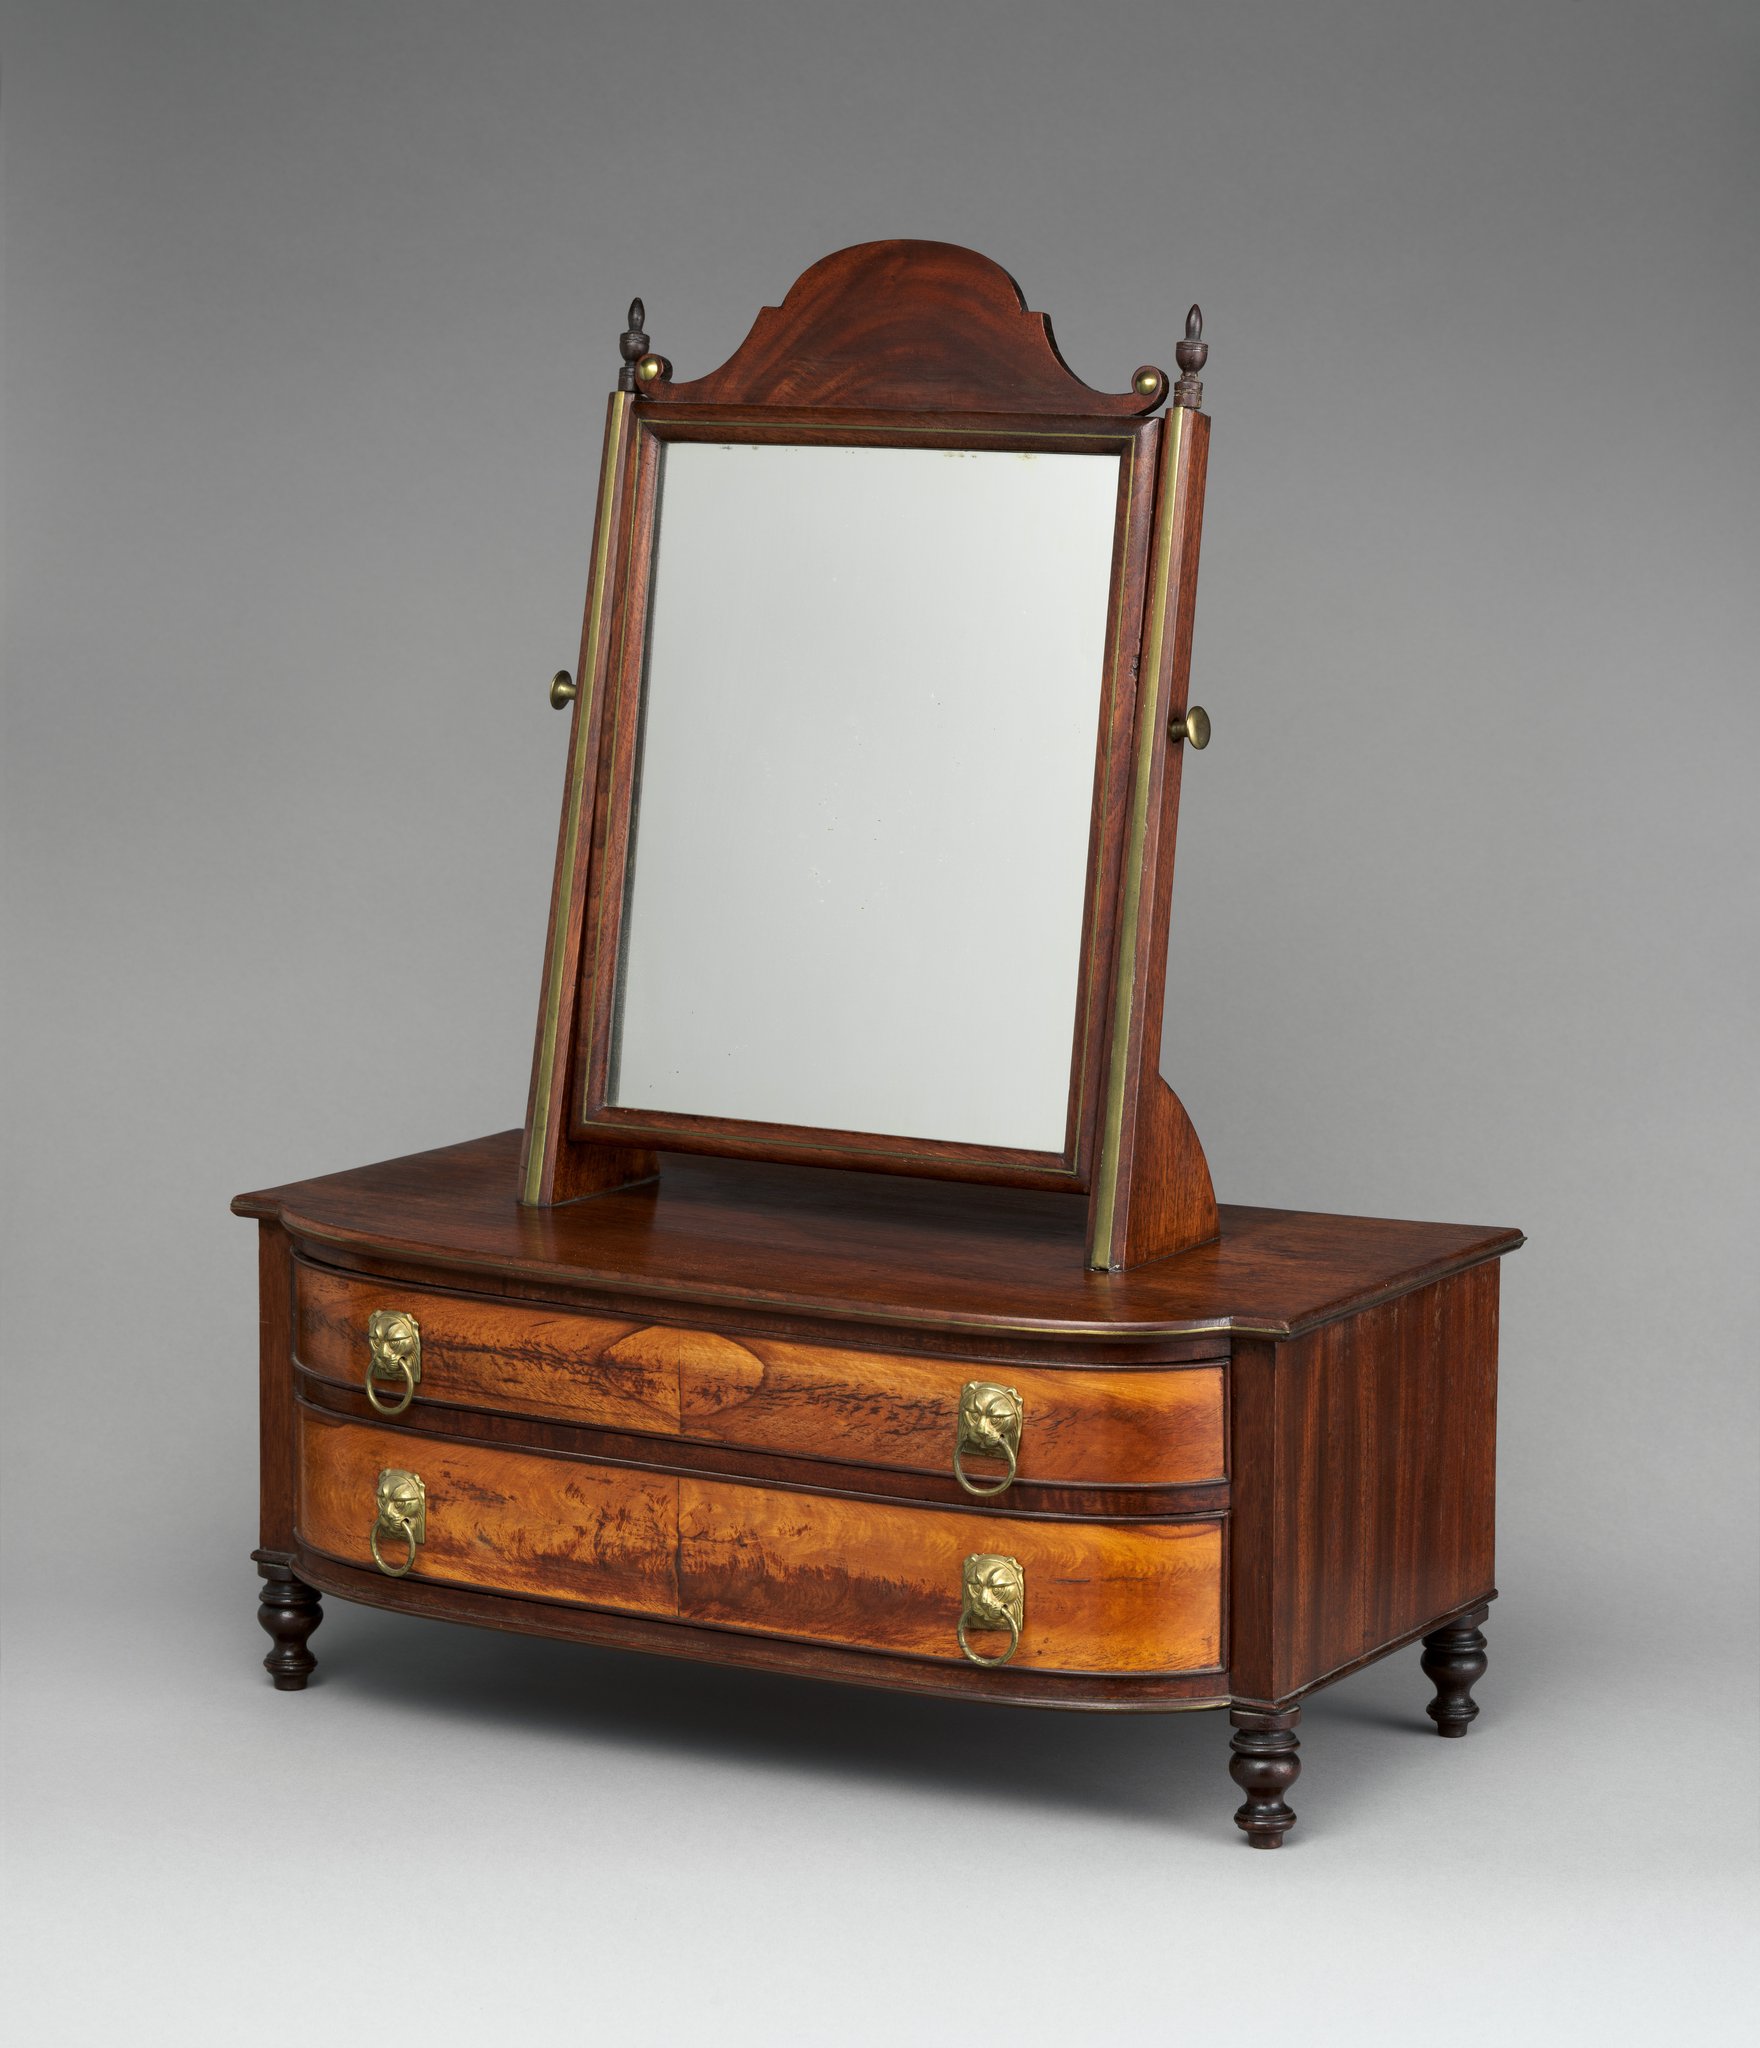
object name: dressing glass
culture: american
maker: thomas seymour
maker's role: maker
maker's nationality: american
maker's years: 1771-1848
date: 1810-1815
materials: wood, glass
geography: united states